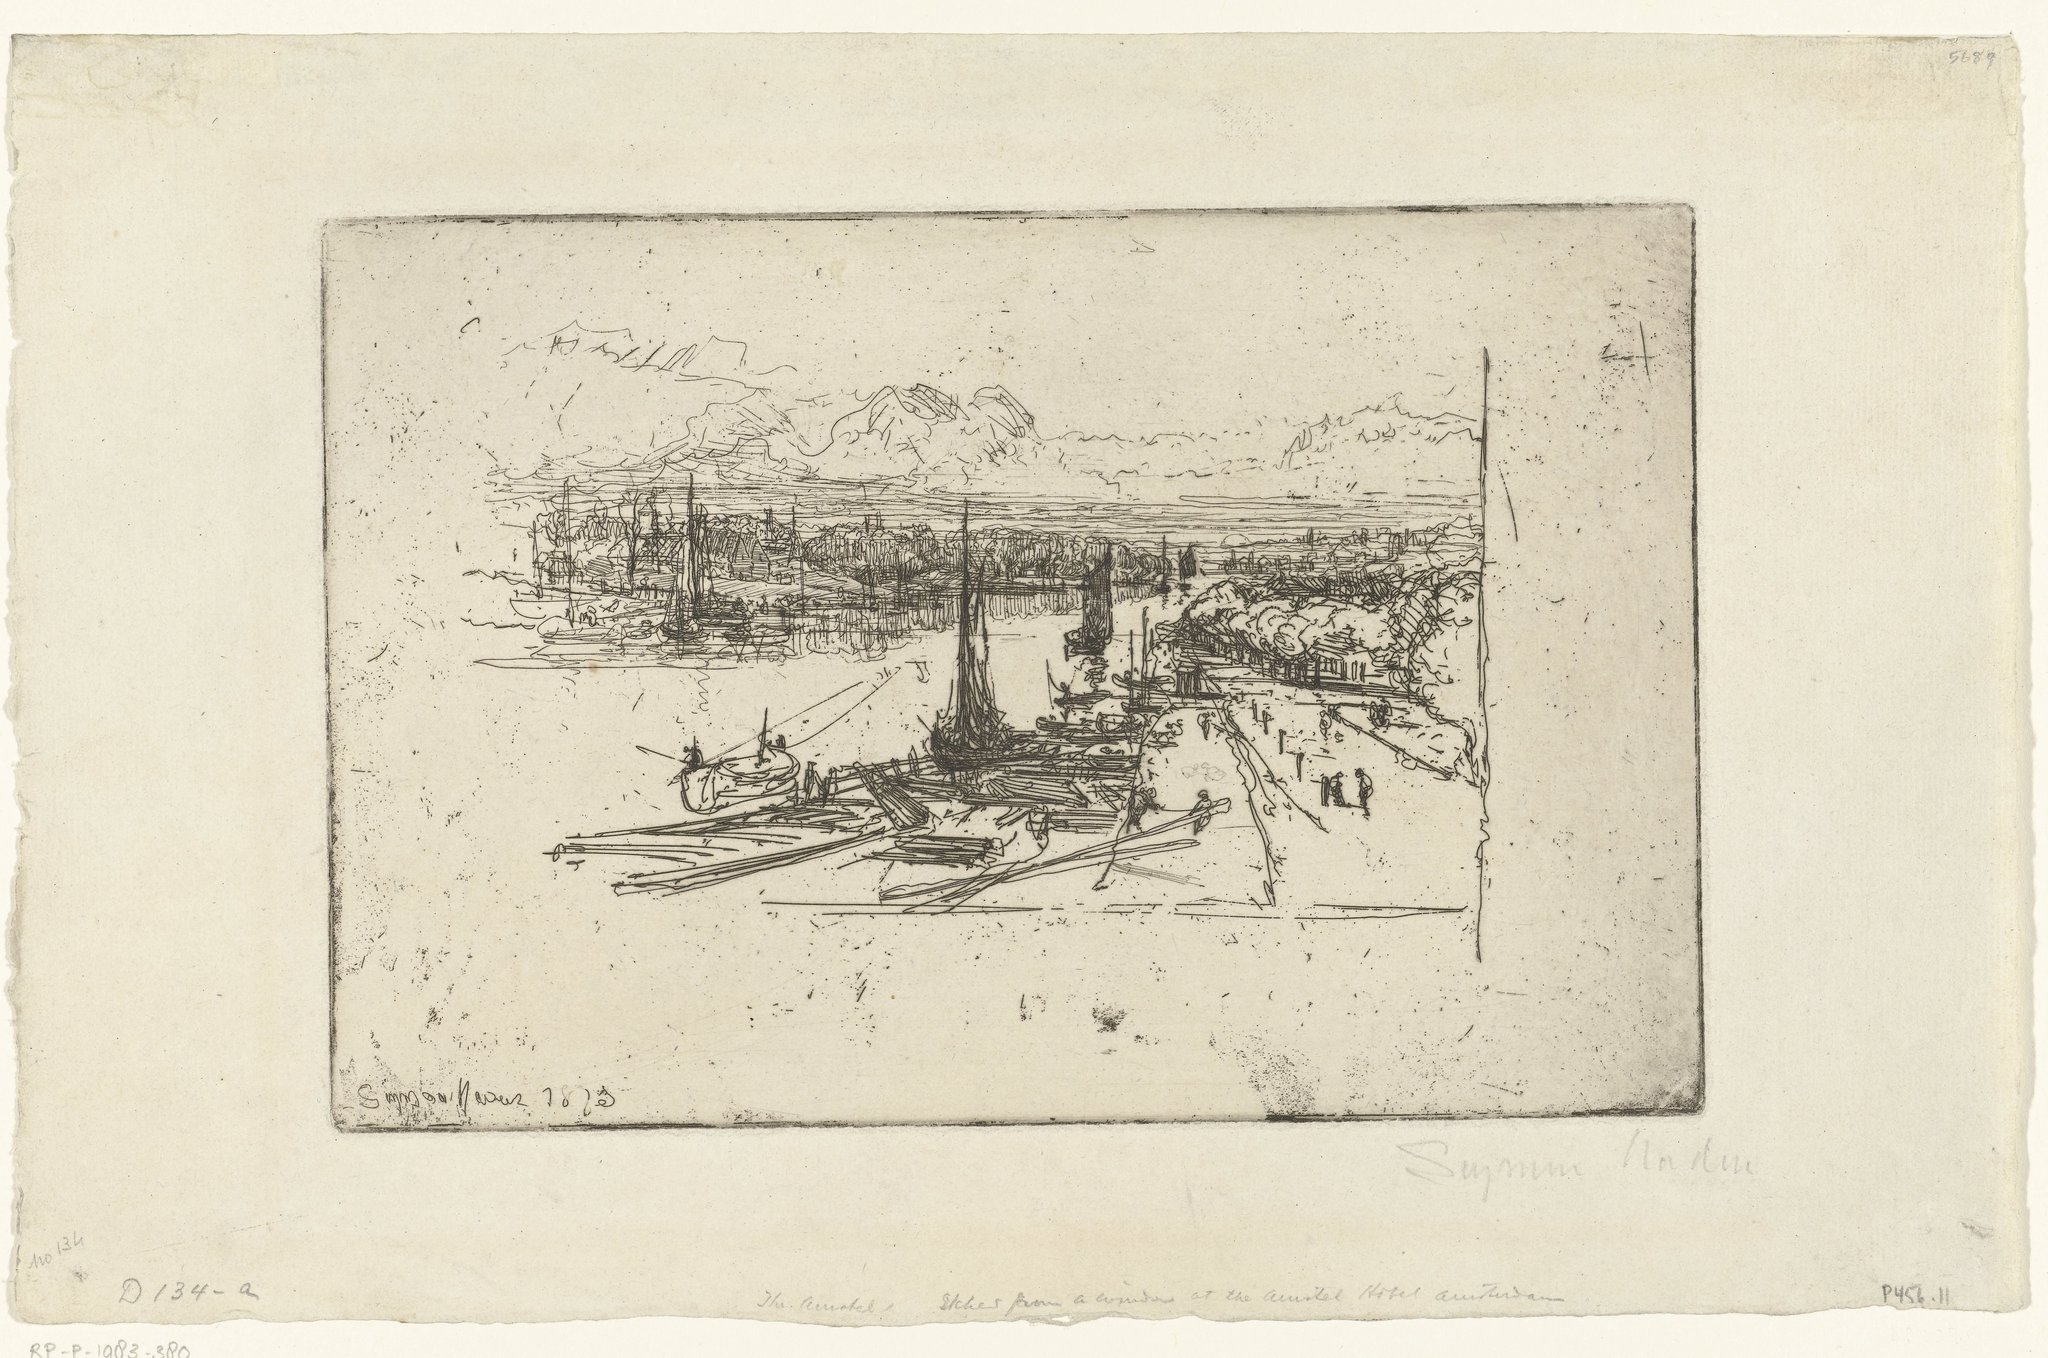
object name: print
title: The Amstel (a Memorandum)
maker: francis seymour-haden (sir)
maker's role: print maker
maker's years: 1818-1910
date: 1873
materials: paper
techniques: etching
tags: city-view in general; 'veduta', amsterdam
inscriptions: signature: ‘Seymour Haden’, collector's mark: Lugt 2228, collector's mark: Lugt 2760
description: Gezicht op de Amstel vanuit het Amstelhotel in Amsterdam.